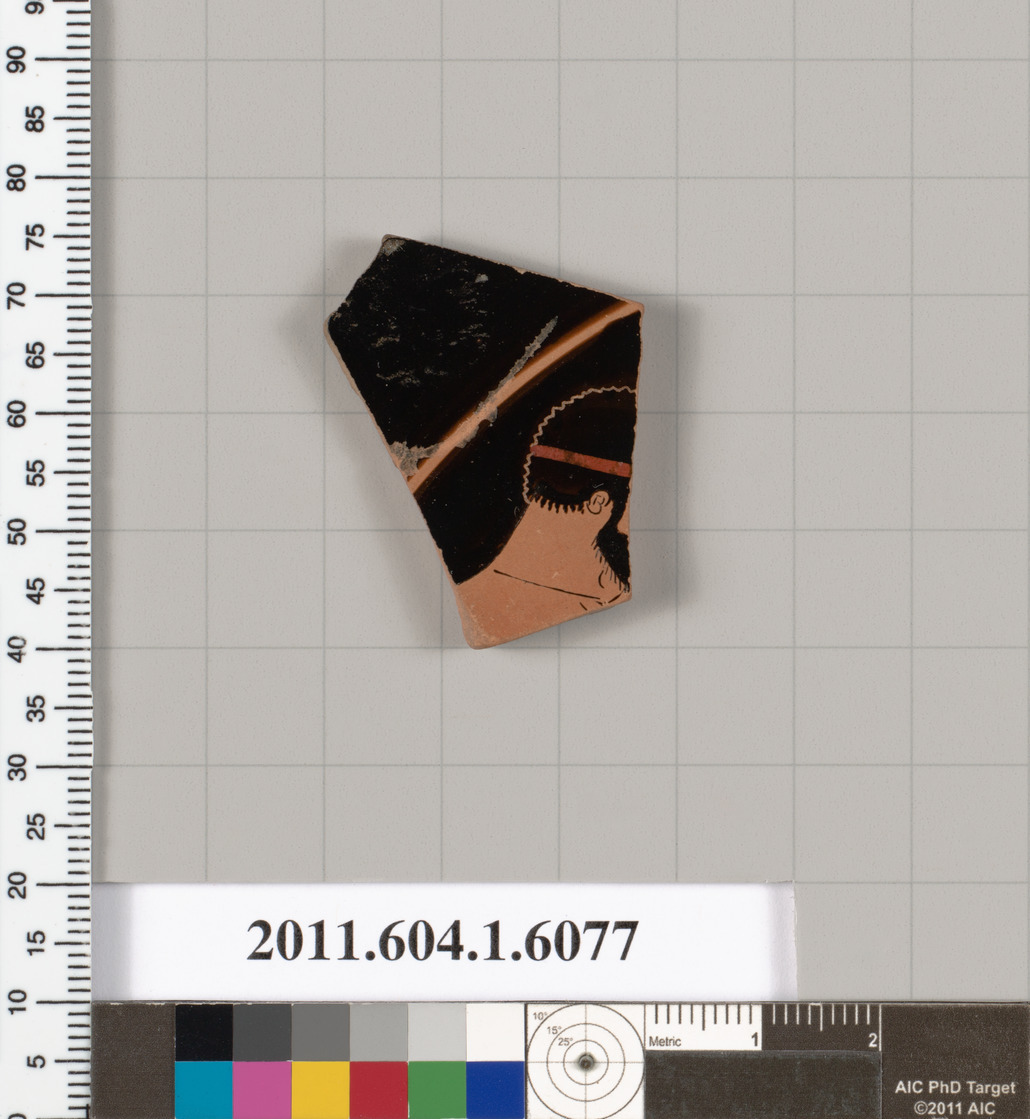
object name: kylix fragment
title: Terracotta fragment of a kylix (drinking cup)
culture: greek, attic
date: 500-490 BCE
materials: terracotta